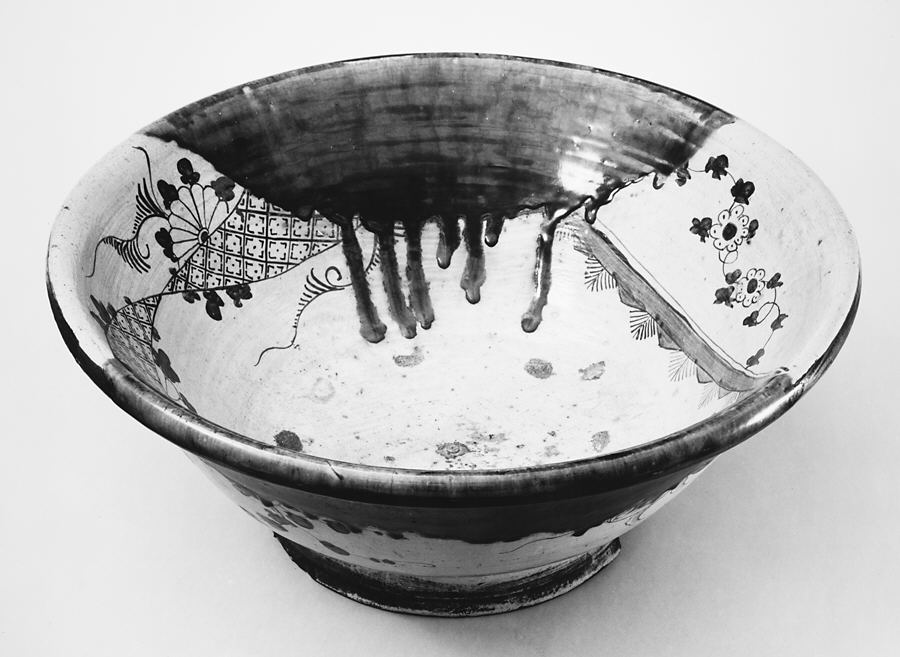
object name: bowl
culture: japanese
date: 1801-1833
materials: stoneware